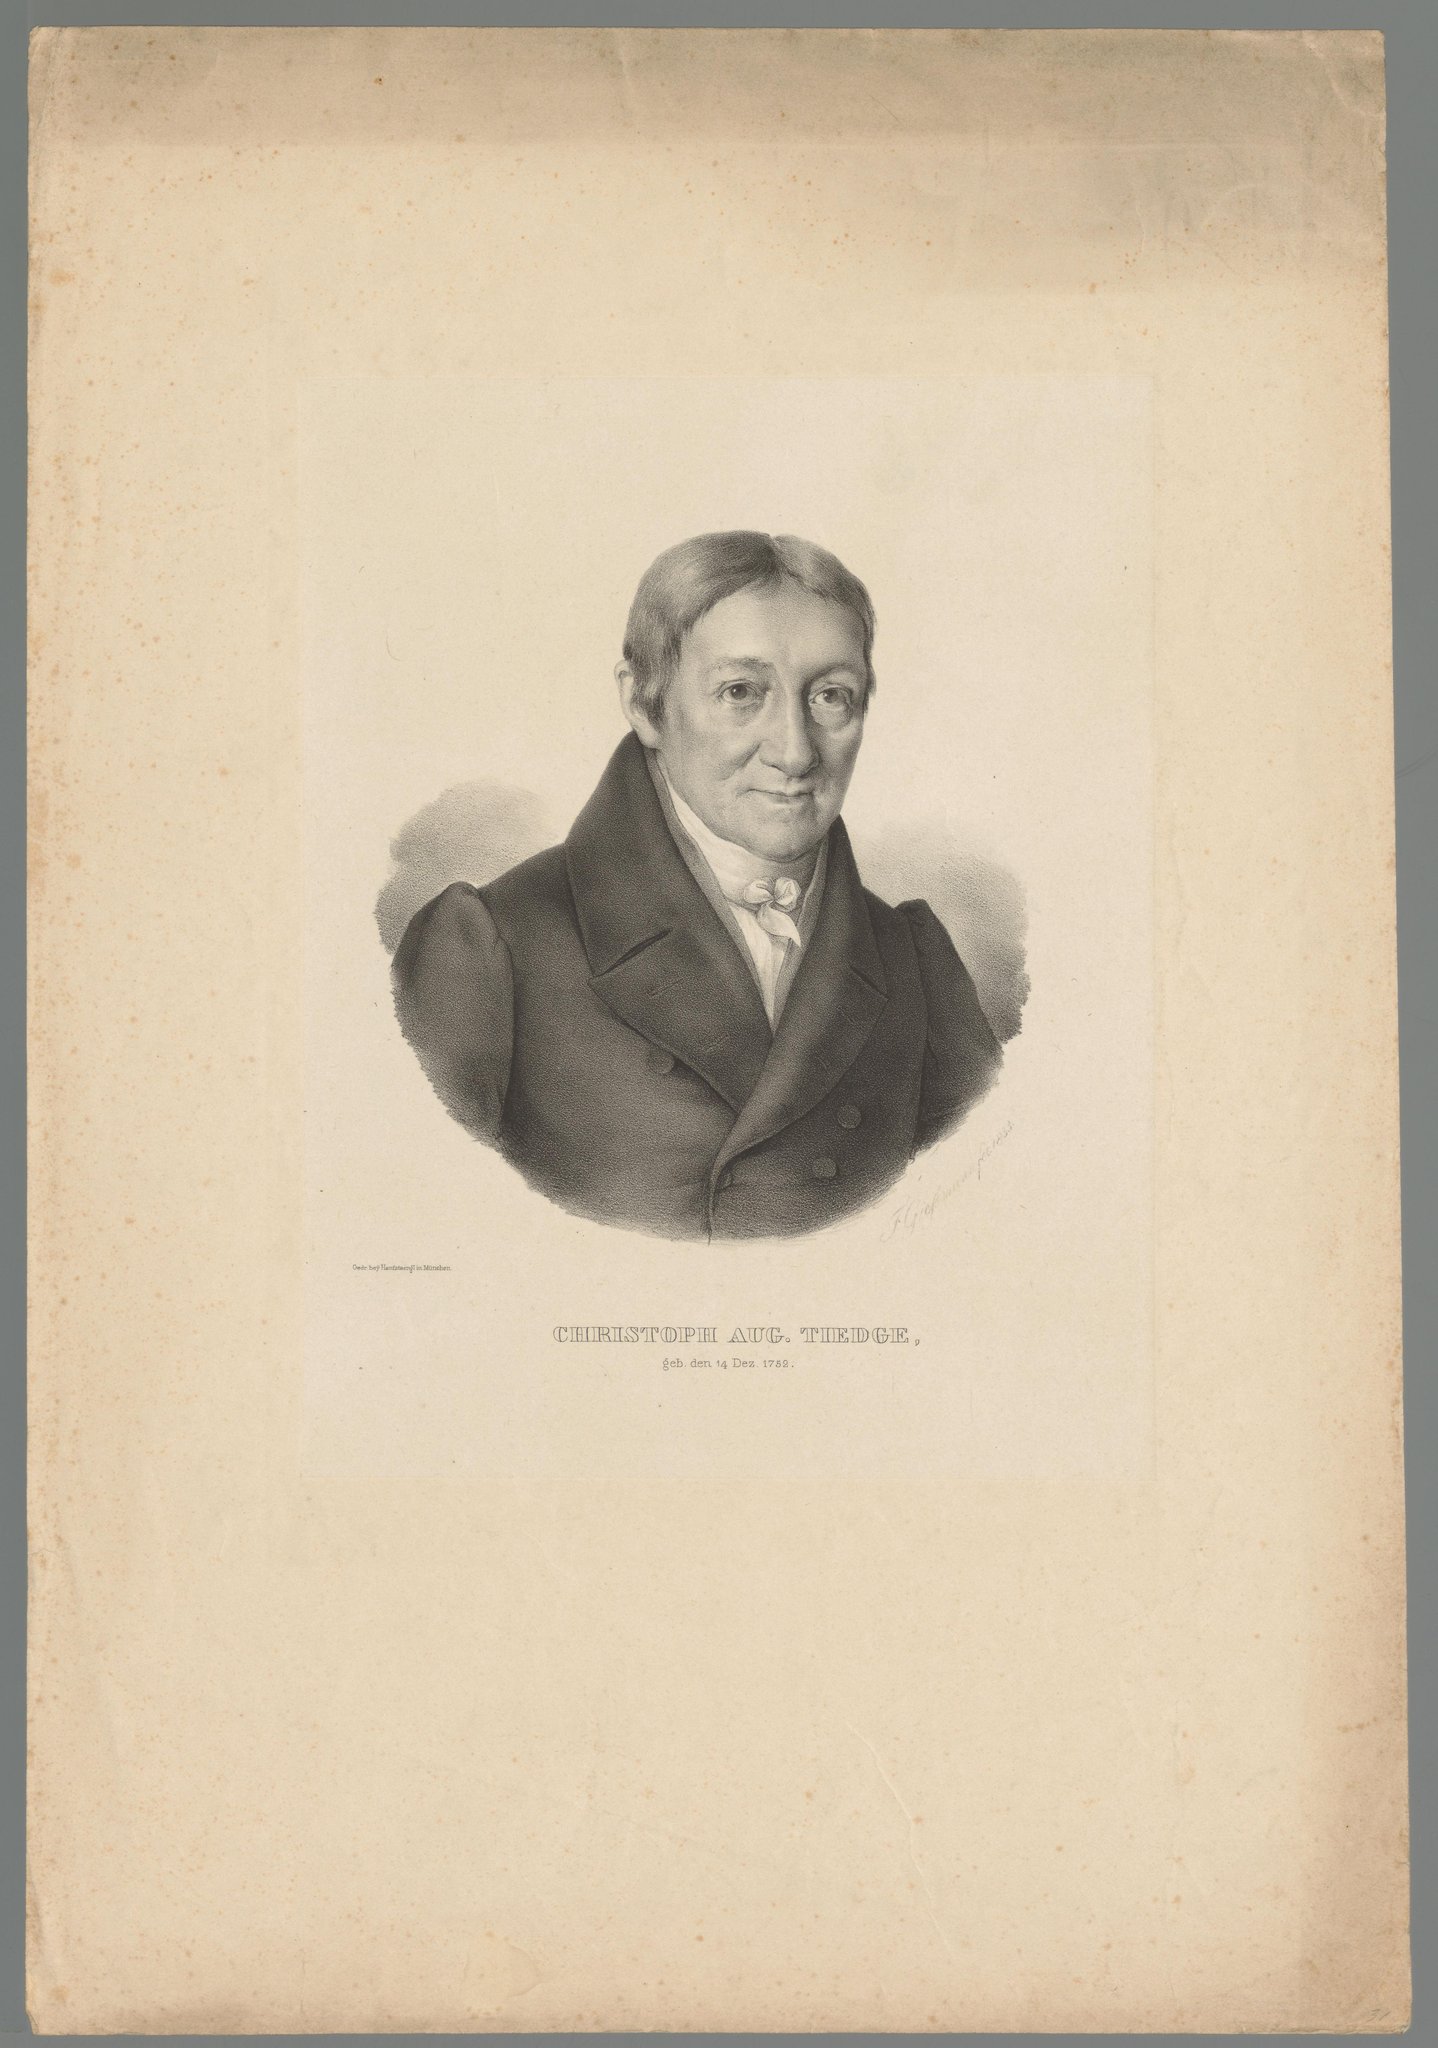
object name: print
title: Christoph Aug. Tiedge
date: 1833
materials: paper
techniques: lithograph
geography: munich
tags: christoph august tiedge, adult man, historical persons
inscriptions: collector's mark: Lugt 2228